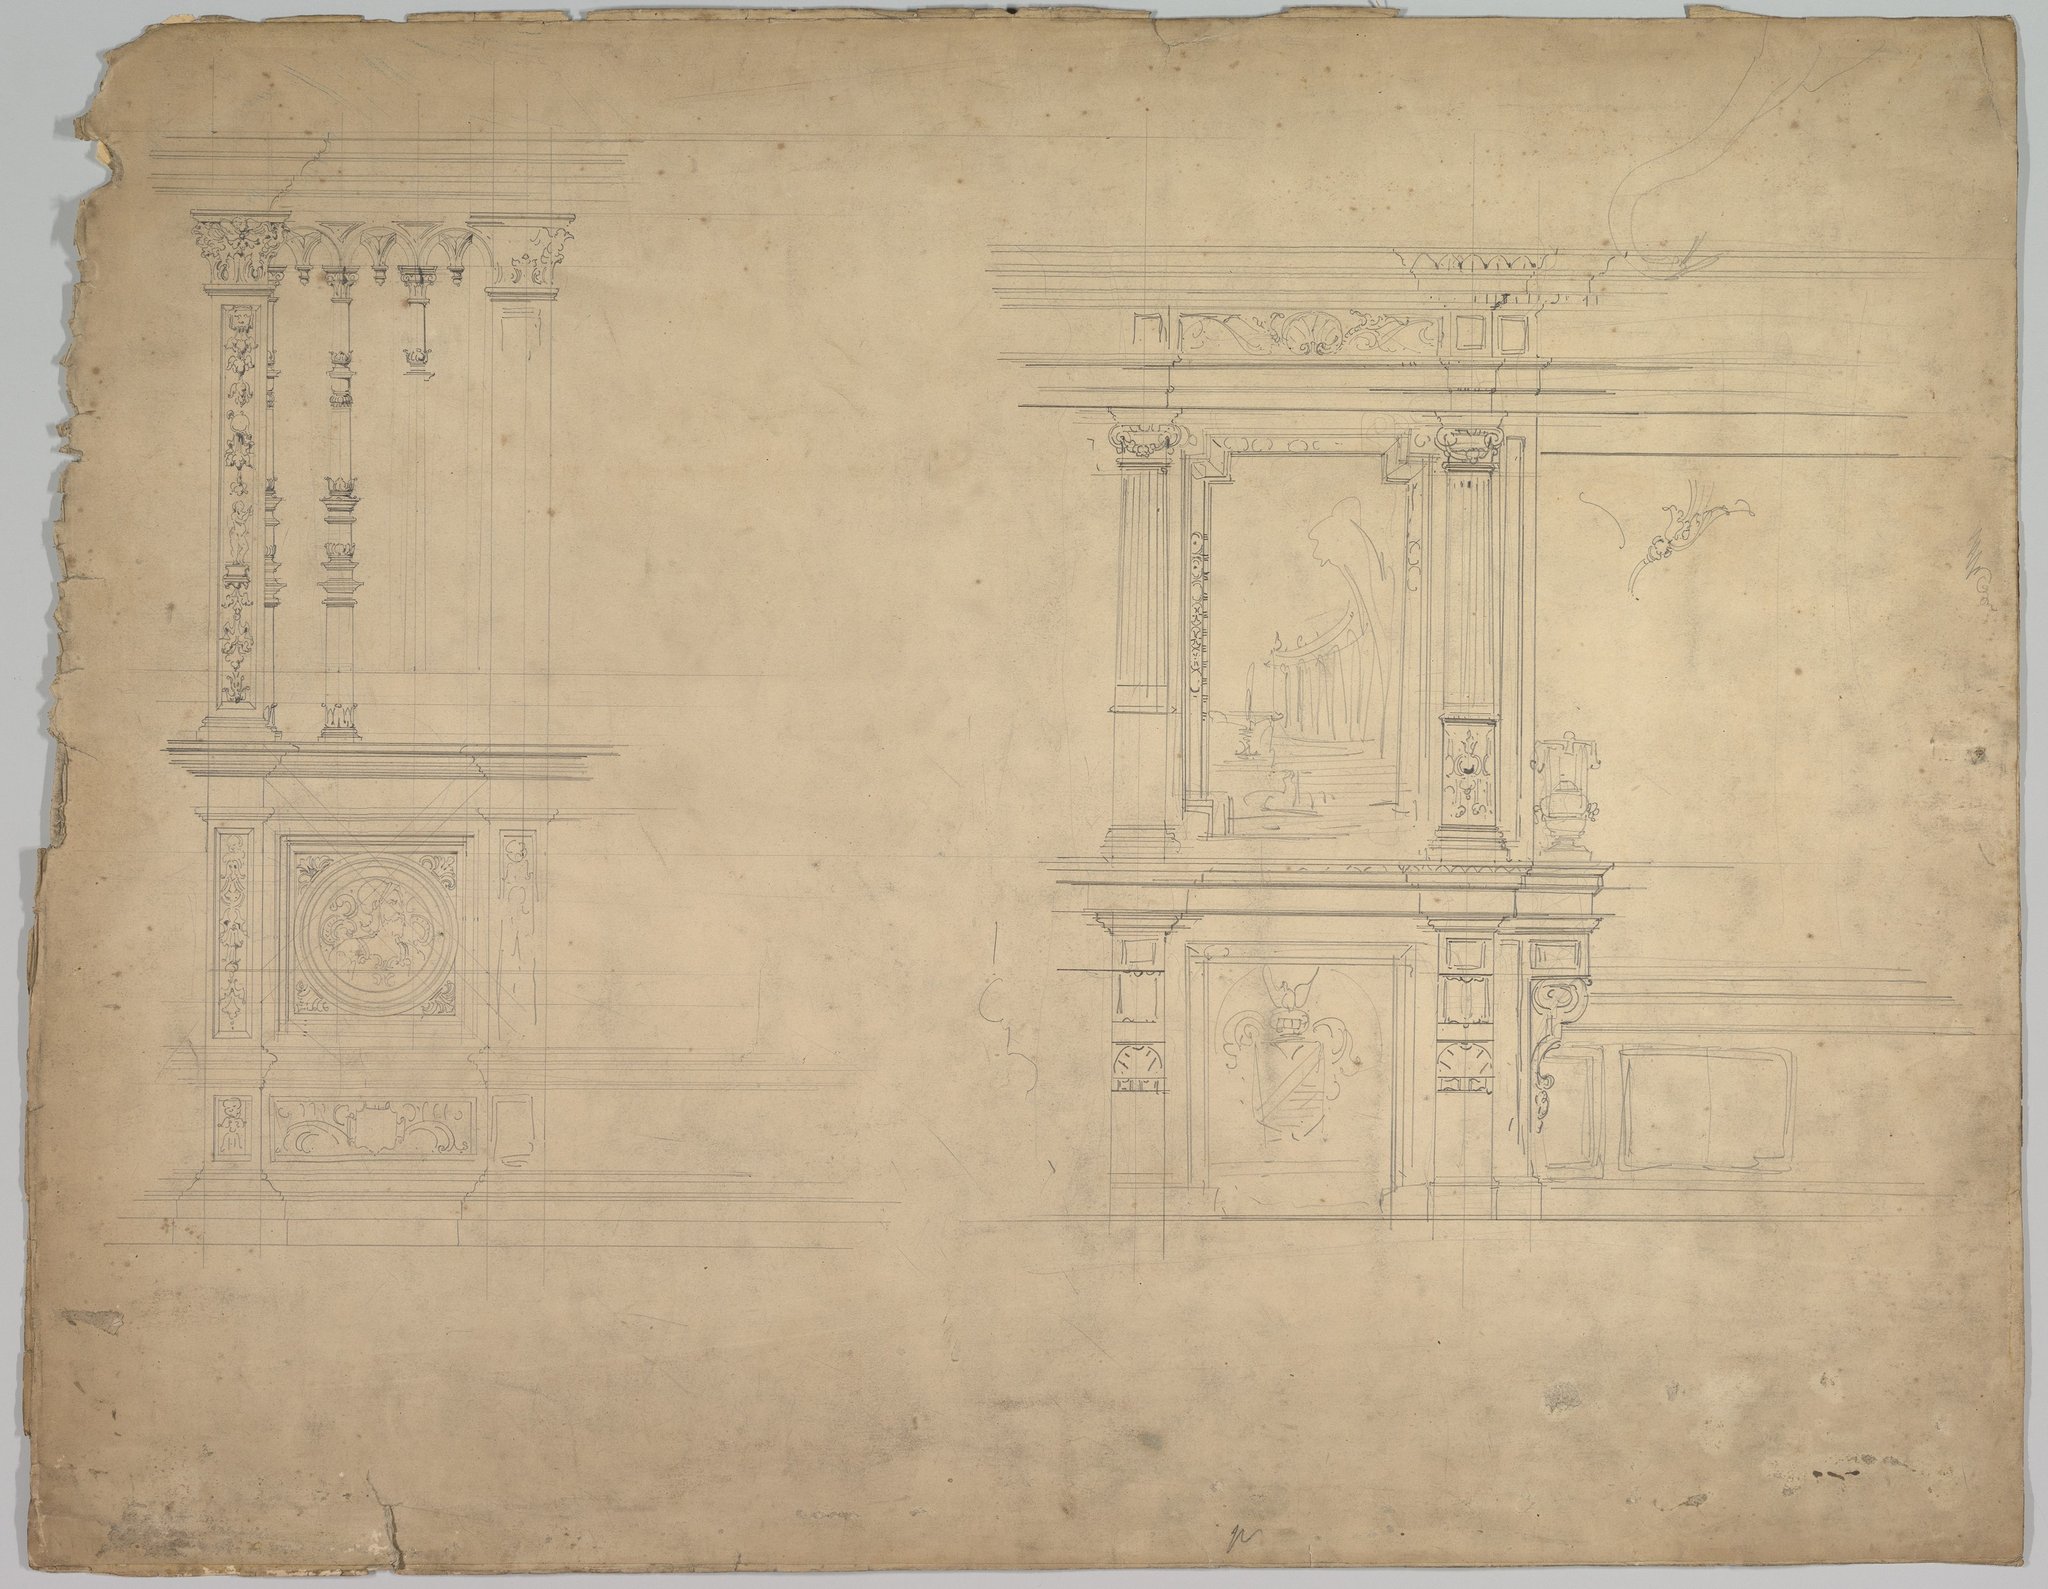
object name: drawing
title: Design for a Stage Set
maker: eugène cicéri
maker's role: artist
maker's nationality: french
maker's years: 1813-1890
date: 1828-1890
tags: stage design